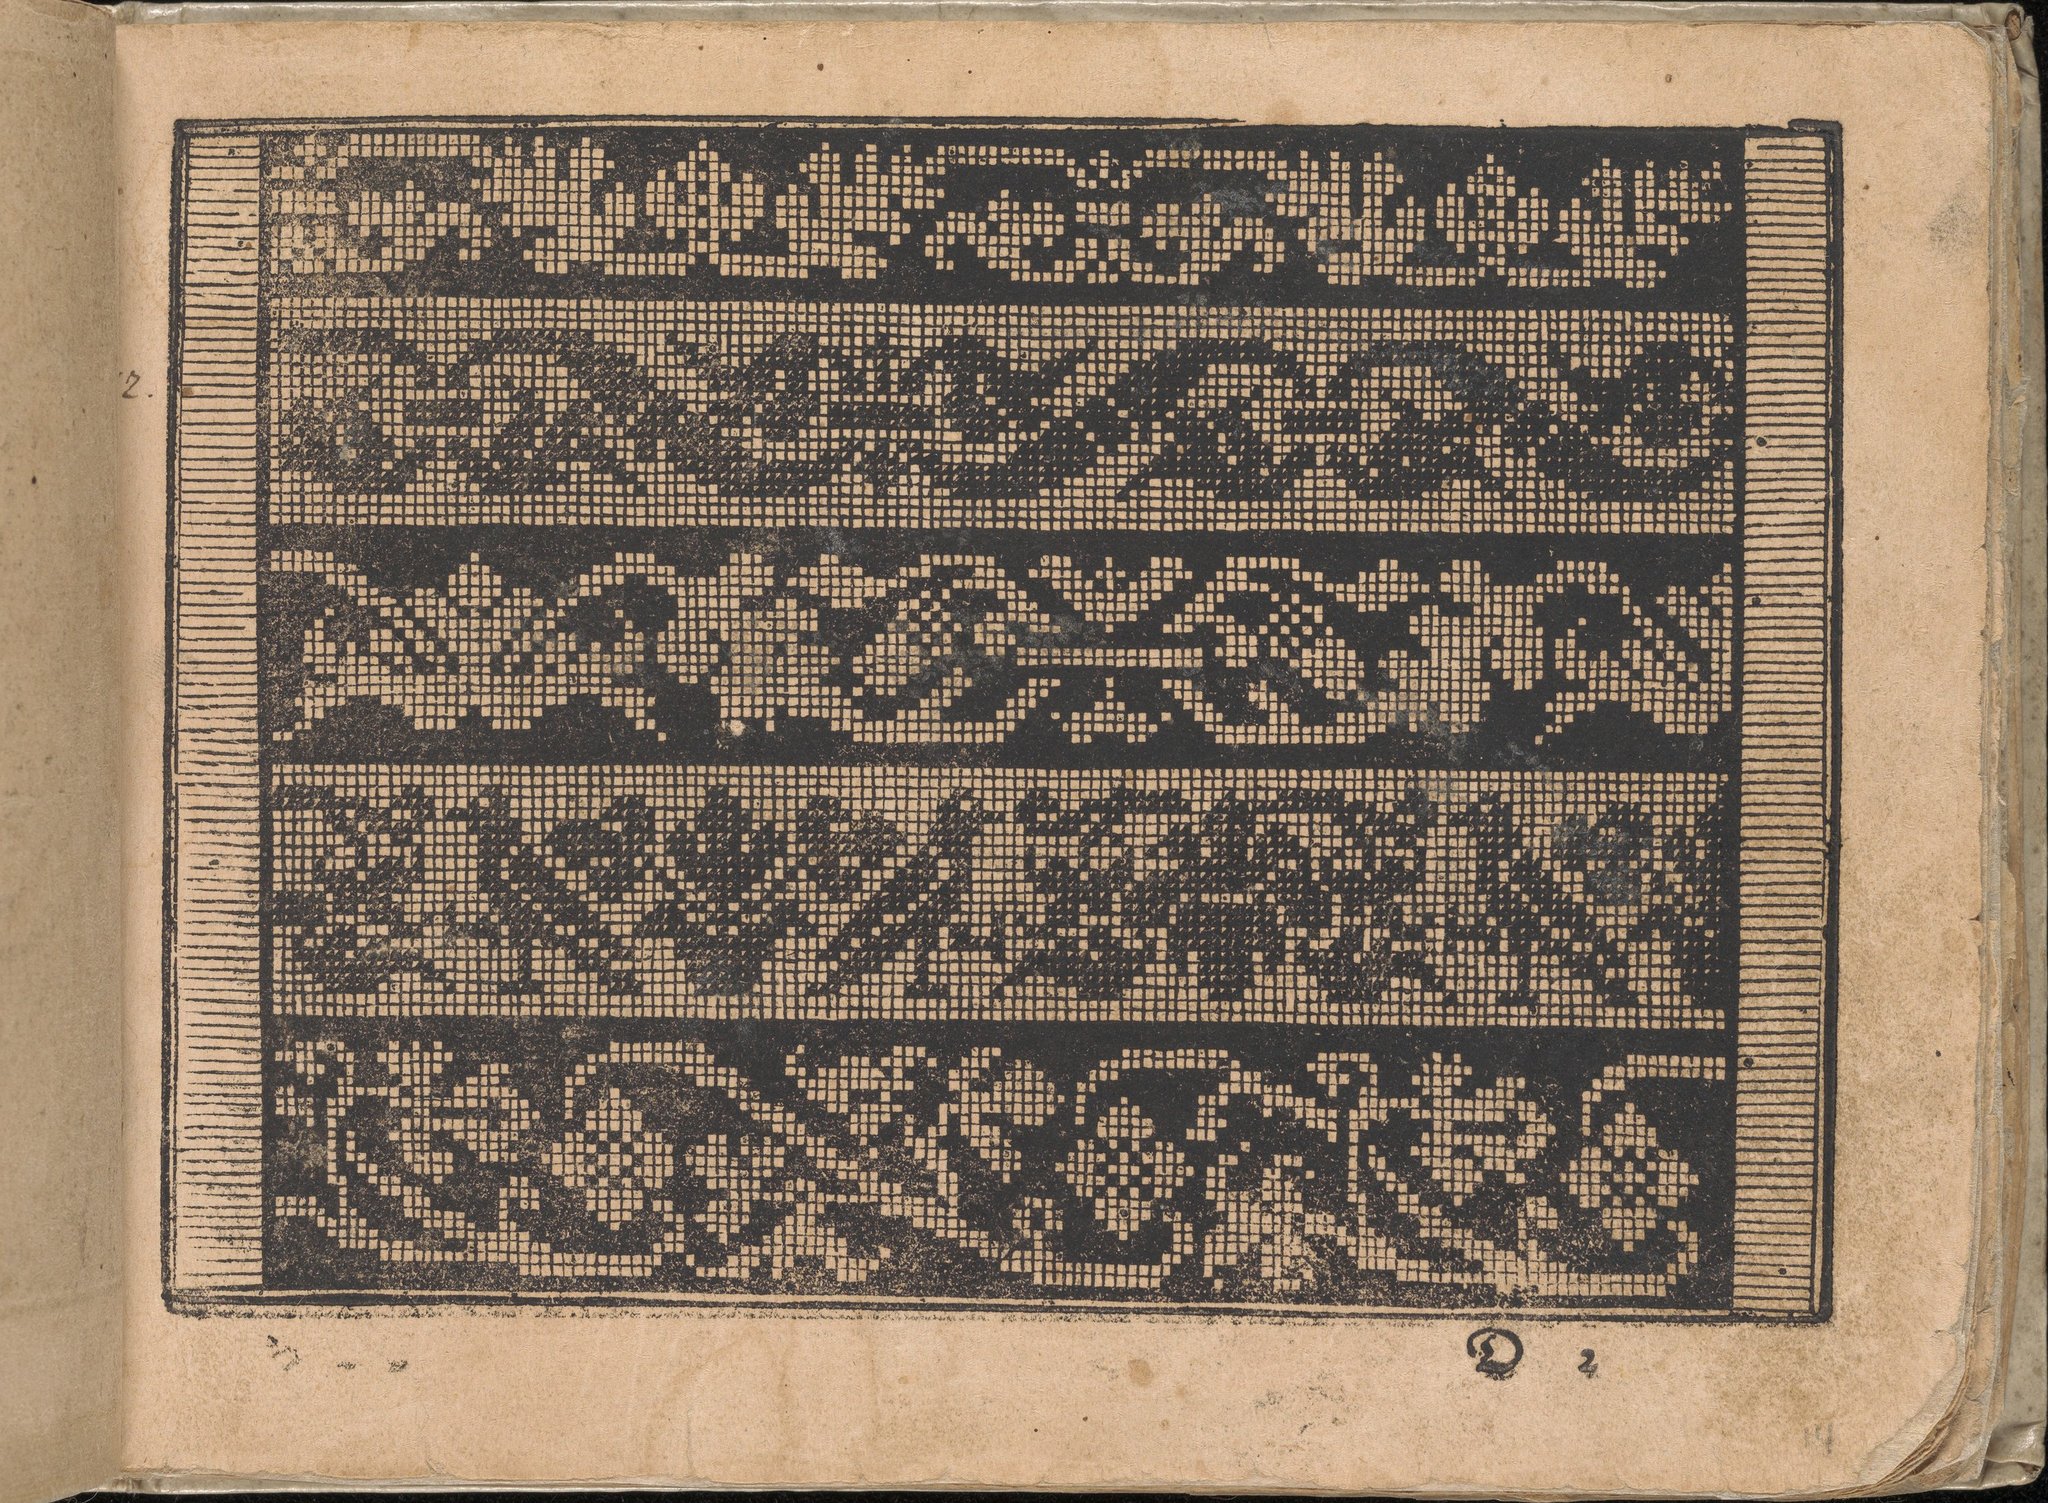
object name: book print ornament architecture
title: Neu künstlich Modelbuch (page 14r)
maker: bernhard jobin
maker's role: publisher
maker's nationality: swiss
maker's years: 1535-1597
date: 1598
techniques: woodcut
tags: birds,ornament